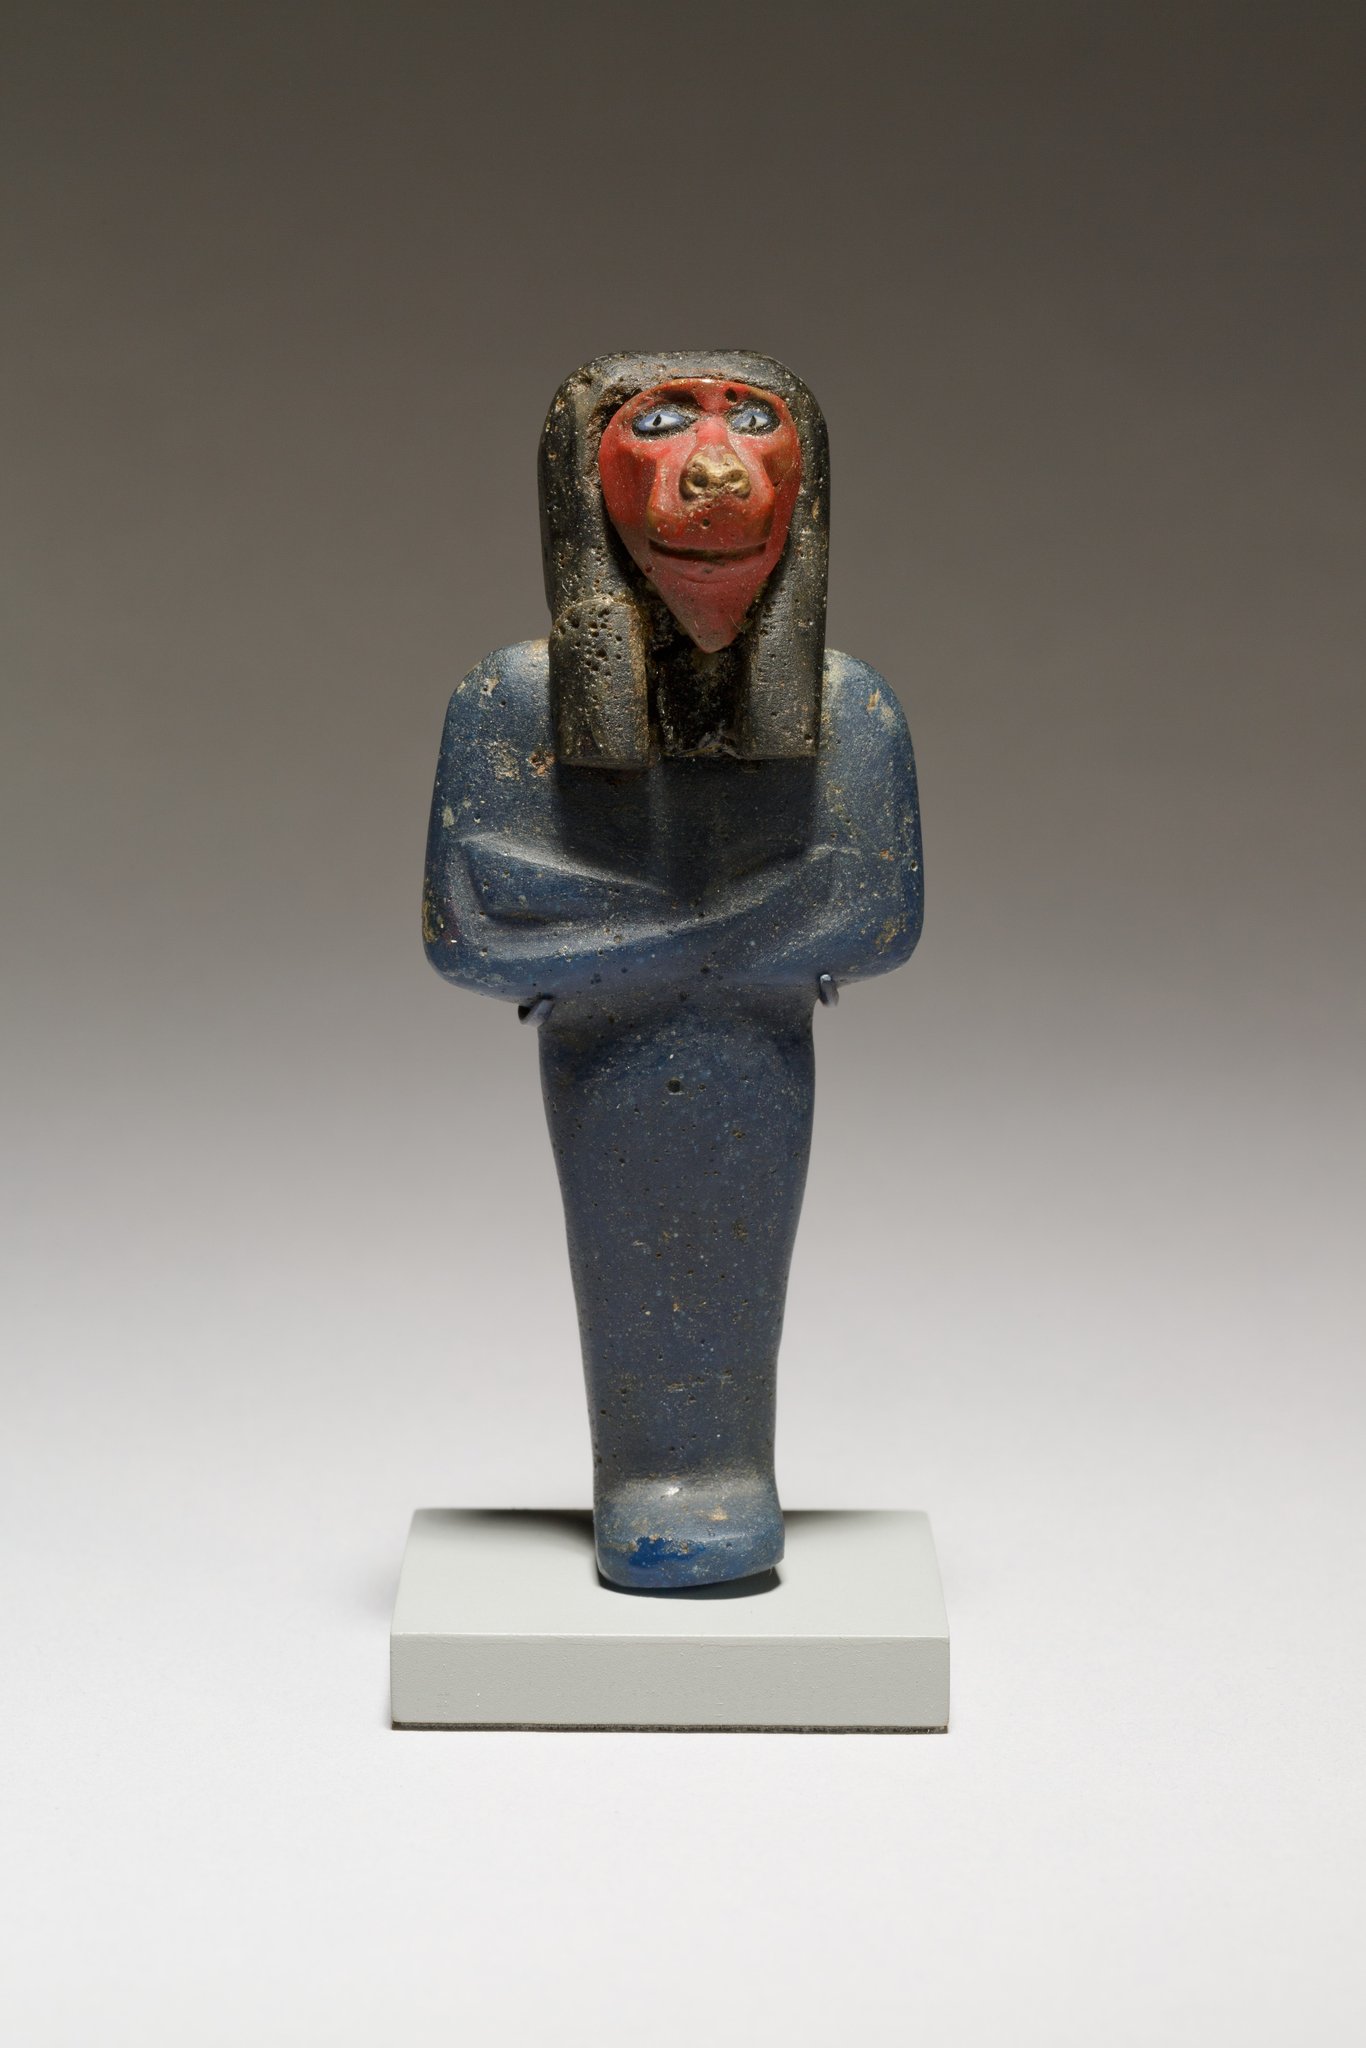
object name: funerary figure, hapy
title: Funerary figure of Hapy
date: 1100-332 BCE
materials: glass, metal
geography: egypt